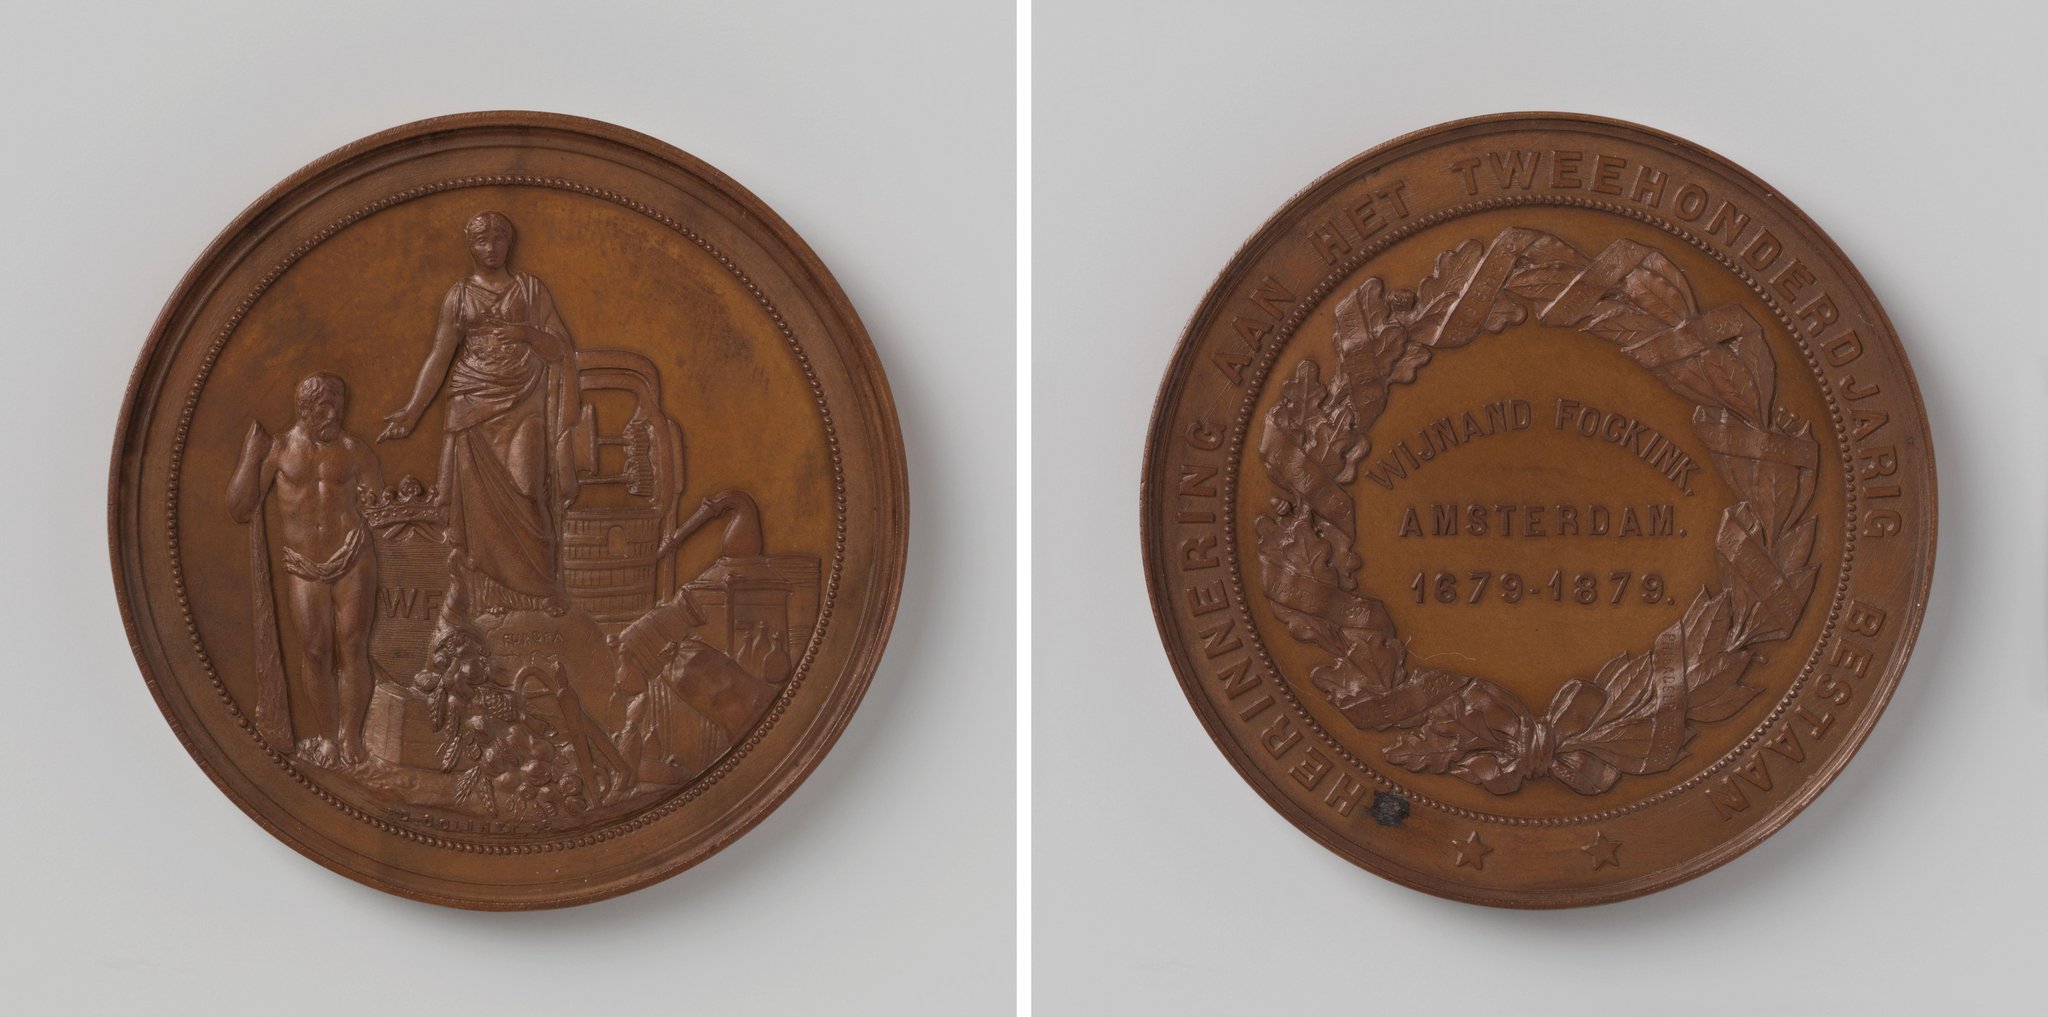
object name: history medal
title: Tweehonderjarig bestaan van de firma Wijnand Fockink te Amsterdam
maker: emmanuel constant edouard colinet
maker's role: sculptor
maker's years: 1844-1890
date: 1879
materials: bronze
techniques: striking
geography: brussels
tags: amsterdam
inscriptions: inscription: ‘WIJNAND FOCKINK . AMSTERDAM . 1679 - 1879’, signature: ‘ED. COLINET SC.’, circumscription: ‘HERINNERING AAN HET TWEE HONDERD JARIG BESTAAN’